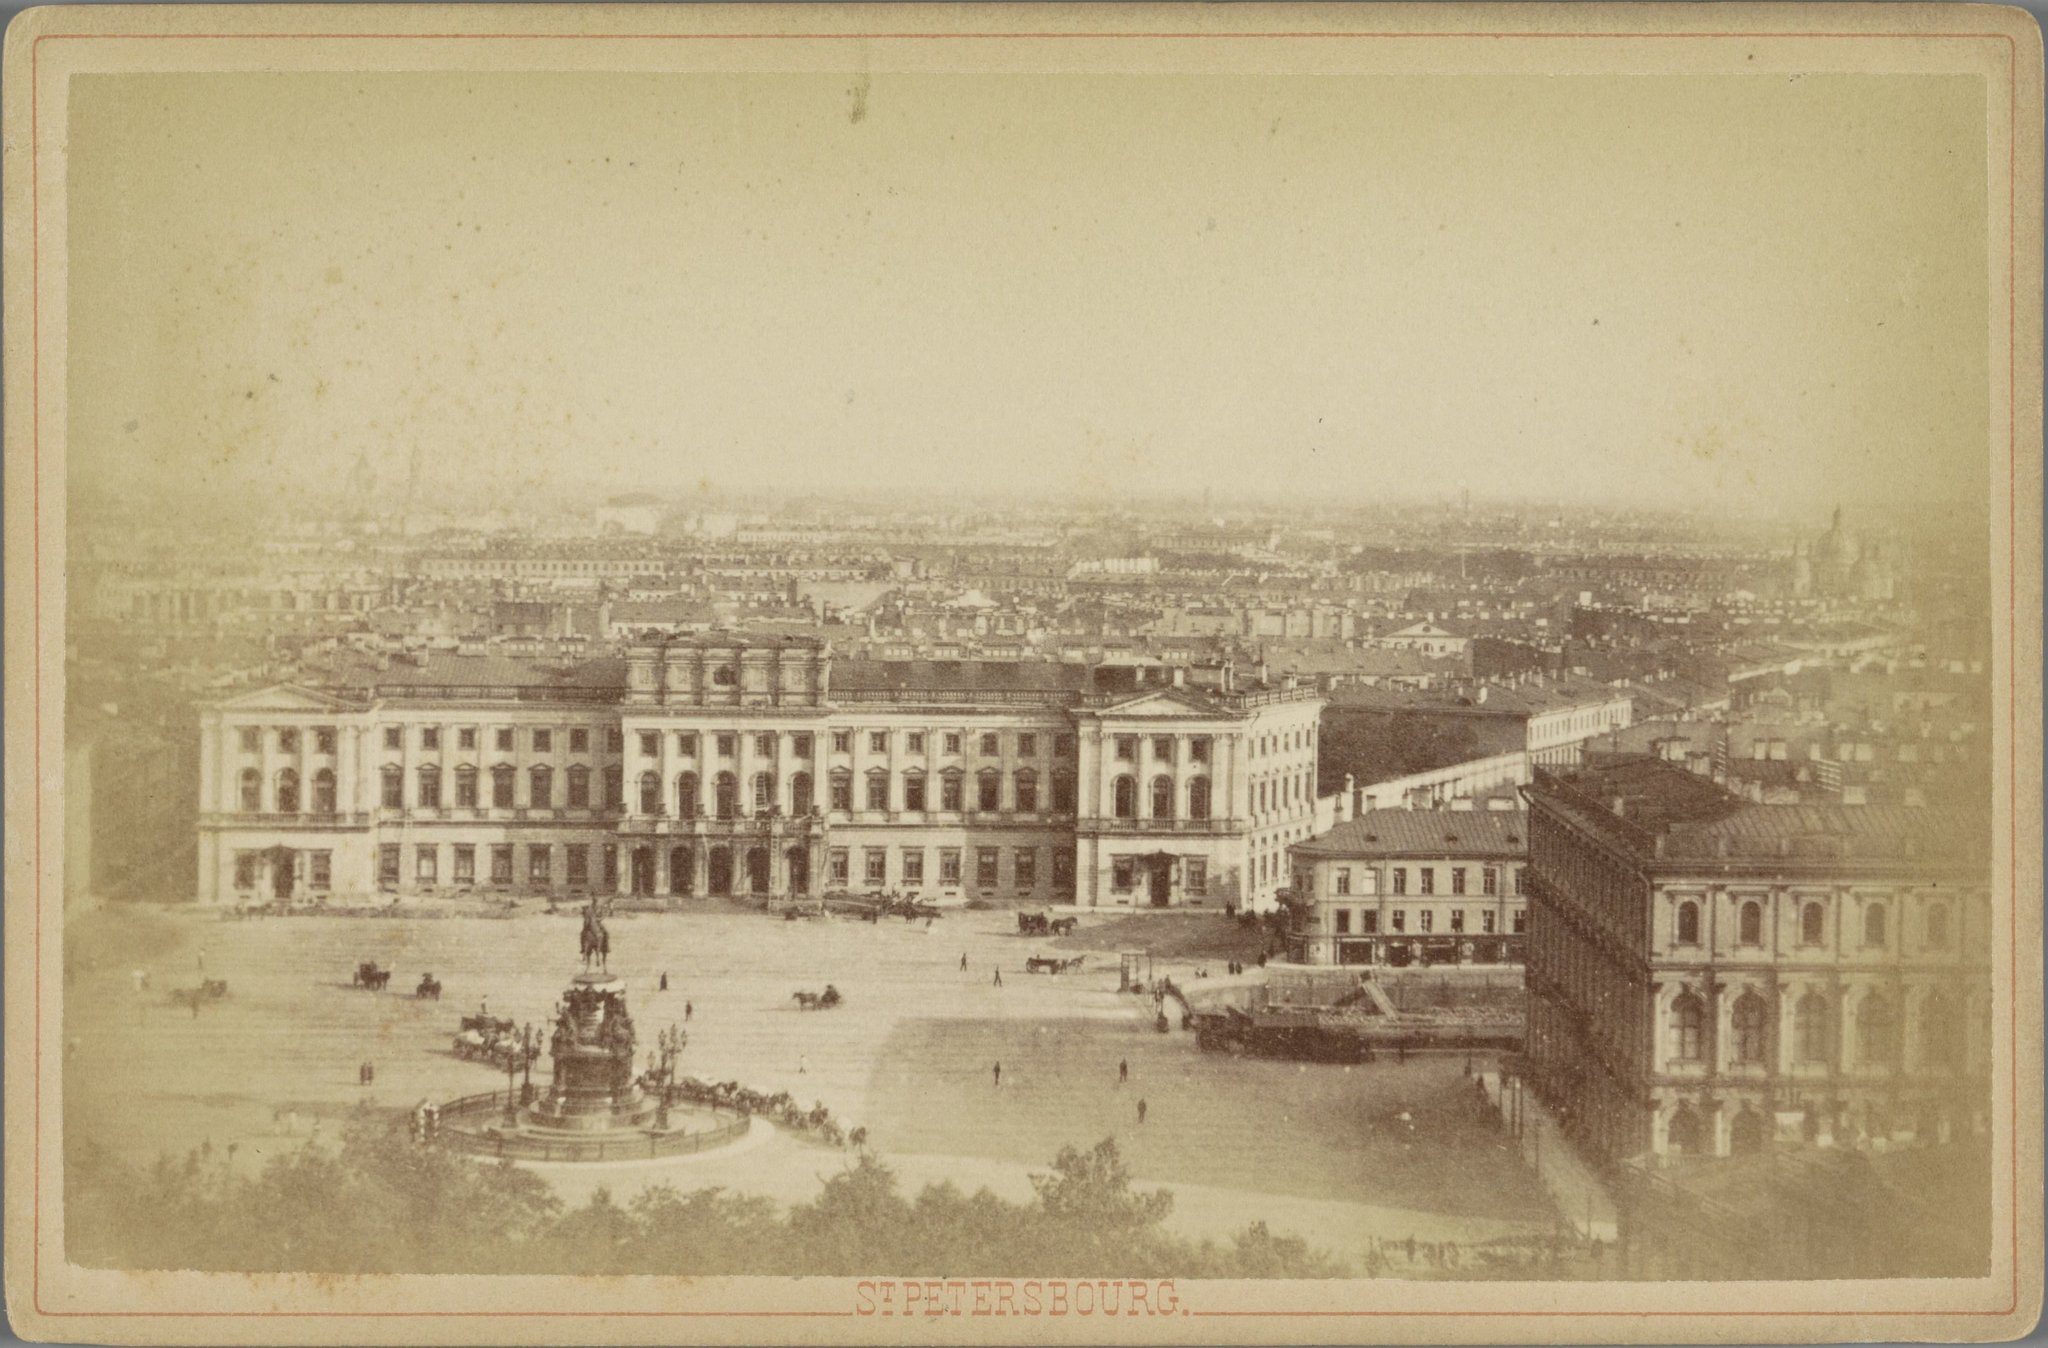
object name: cabinet photograph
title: St. Petersbourg.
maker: joseph daziaro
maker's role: publisher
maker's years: 1831-1892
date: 1880-1900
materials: cardboard, photographic support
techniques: albumen print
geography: sint-petersburg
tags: palace, square, place, circus, etc. (+ city(-scape) with figures, staffage)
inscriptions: inscription: ‘Palais Marie’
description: Onderdeel van Fotoalbum met opnames van Sint-Petersburg.